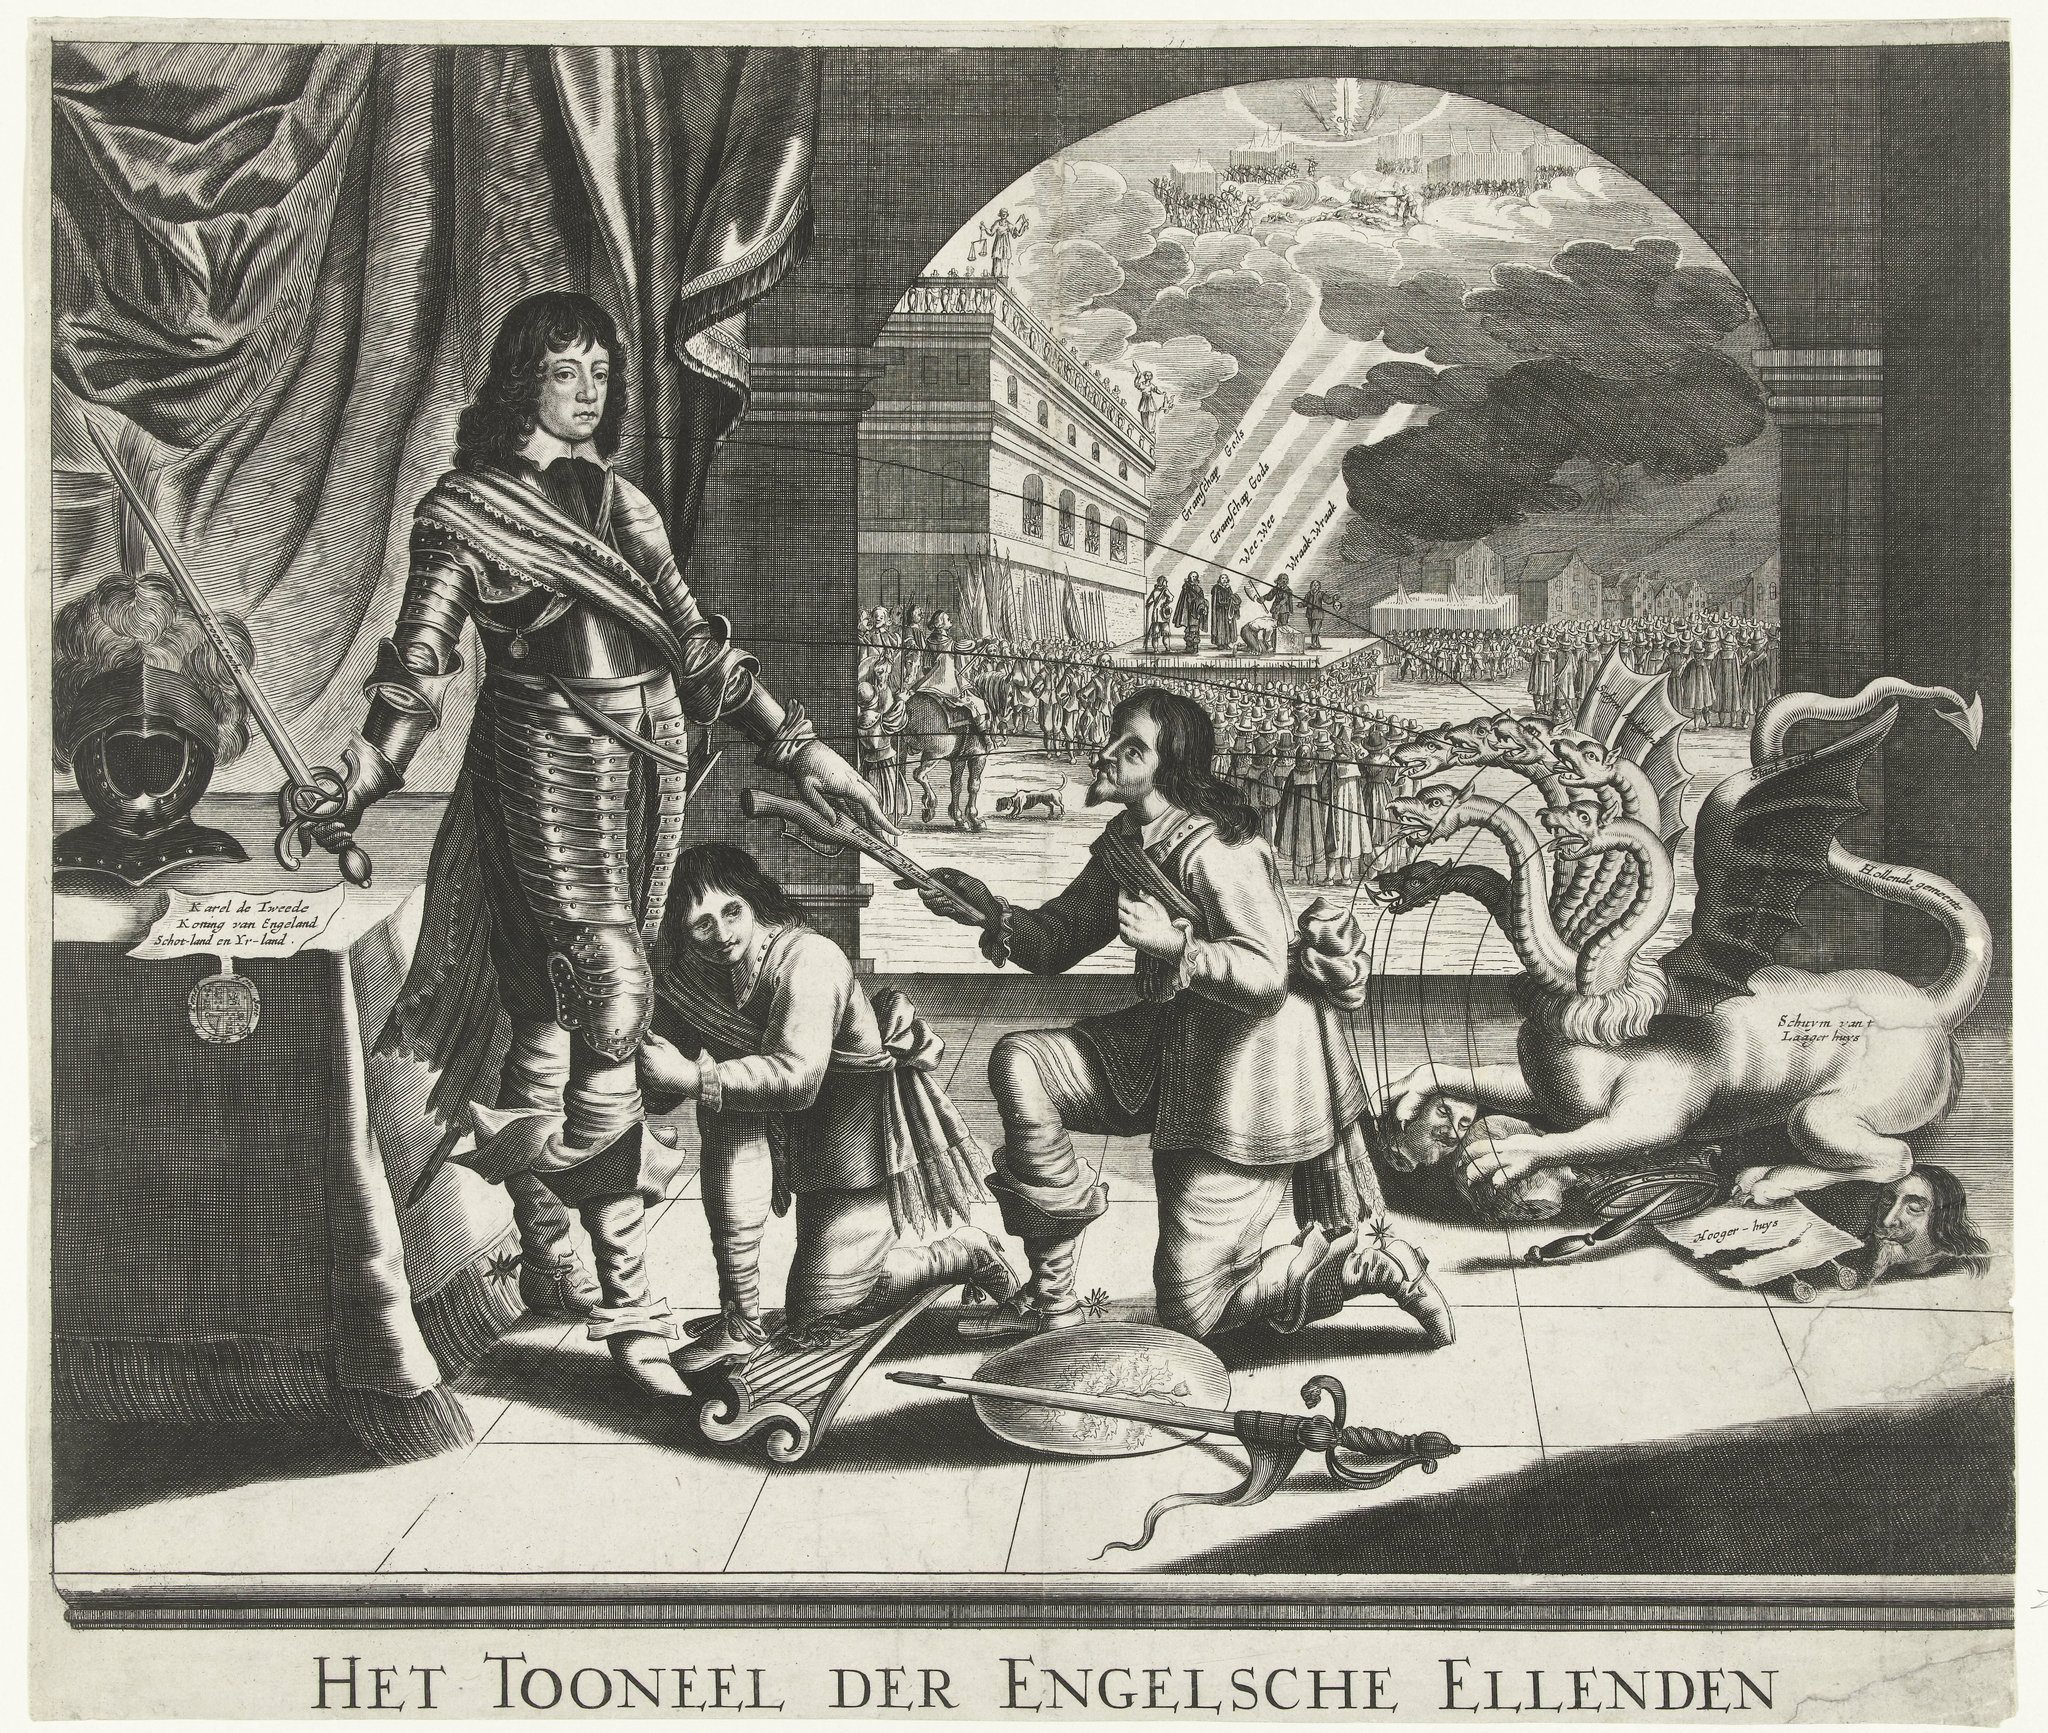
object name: propagandaprent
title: Allegorie op koning Karel II van Engeland, ca. 1651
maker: Anonymous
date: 1651-1652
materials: paper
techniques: engraving, etching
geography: northern netherlands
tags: london, karel i (koning van engeland), karel ii (koning van engeland), violent death by beheading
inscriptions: collector's mark: Lugt 2259a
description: Allegorie op koning Karel II van Engeland, ca. 1651. Karel wordt door Ierland en Schotland zijn wapenrusting aangedaan en een pistool aangereikt om strijd te voeren en de kroon van Engeland op te eisen. Rechts een zevenkoppige draak van het parlement met koninklijke insignia en afgehakte hoofden van onder andere koning Karel I. Op de achtergrond de onthoofding van Karel I bij Whitehall in 1649, uit de hemel schijnen stralen van Gods gramschap en wraak. Bij dit exemplaar ontbreekt de bijbehorende tekstblad.